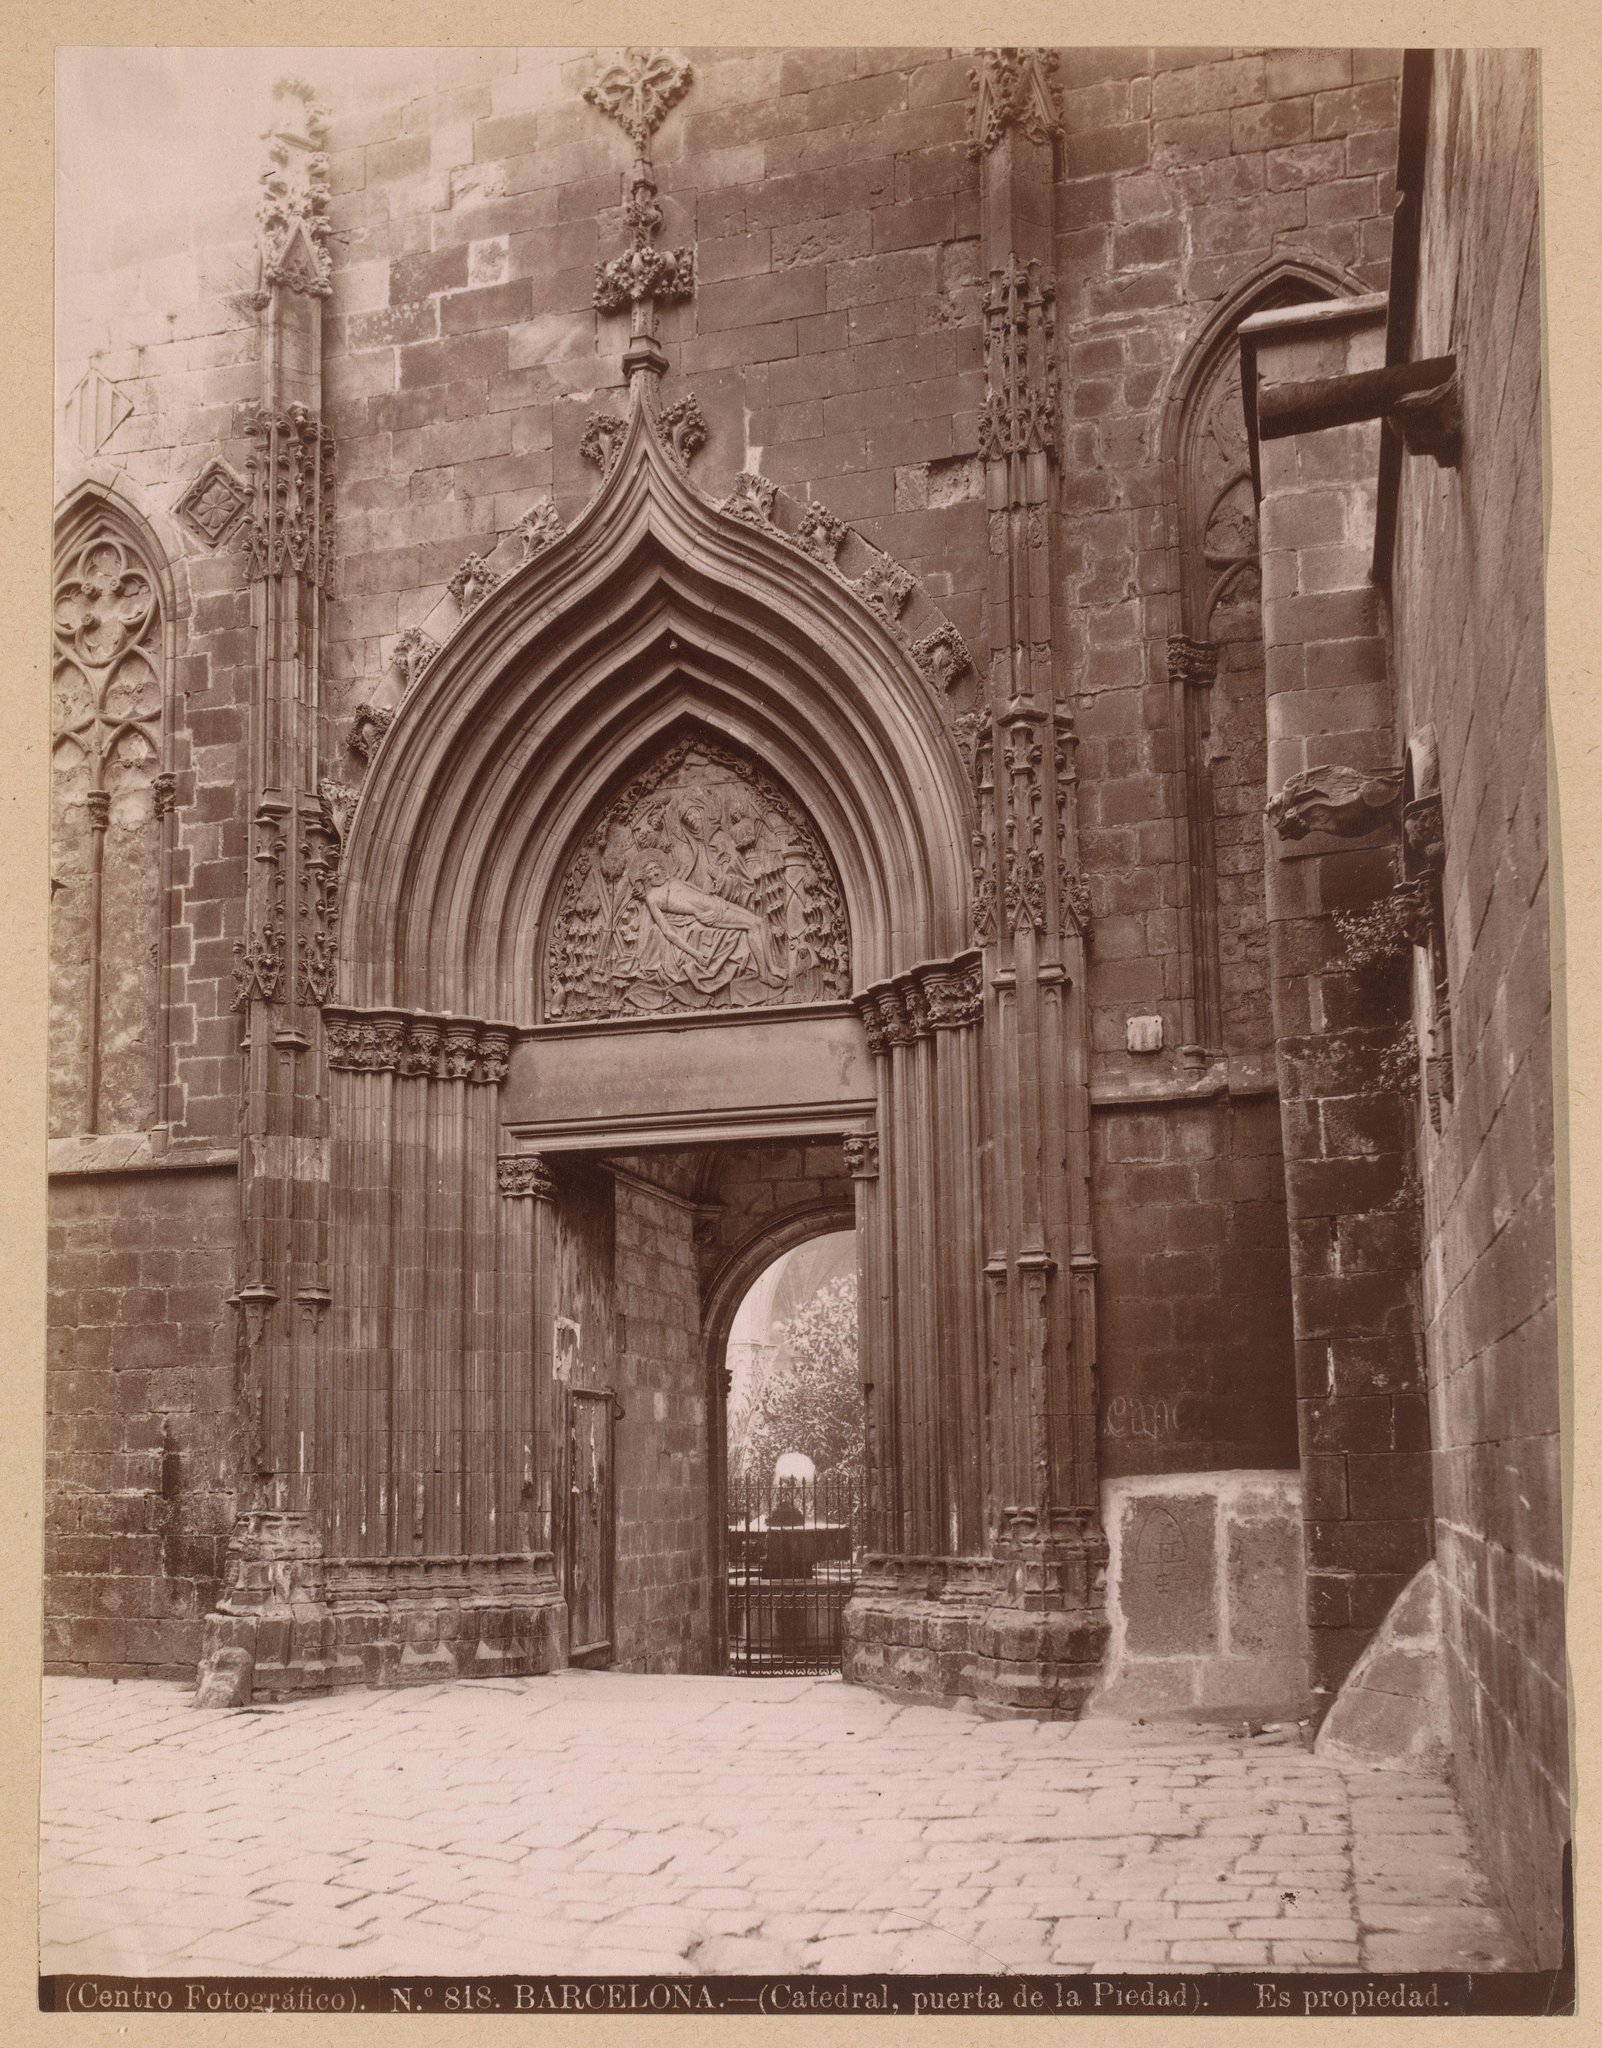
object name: photograph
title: Gezicht op de Puerta de la Piedad in de kathedraal van het Heilig Kruis en Sint Eulalia in Barcelona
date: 1851-1890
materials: paper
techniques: albumen print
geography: barcelona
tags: interior of church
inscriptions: number: ‘No. 818.’, inscription: ‘Es propiedad.’